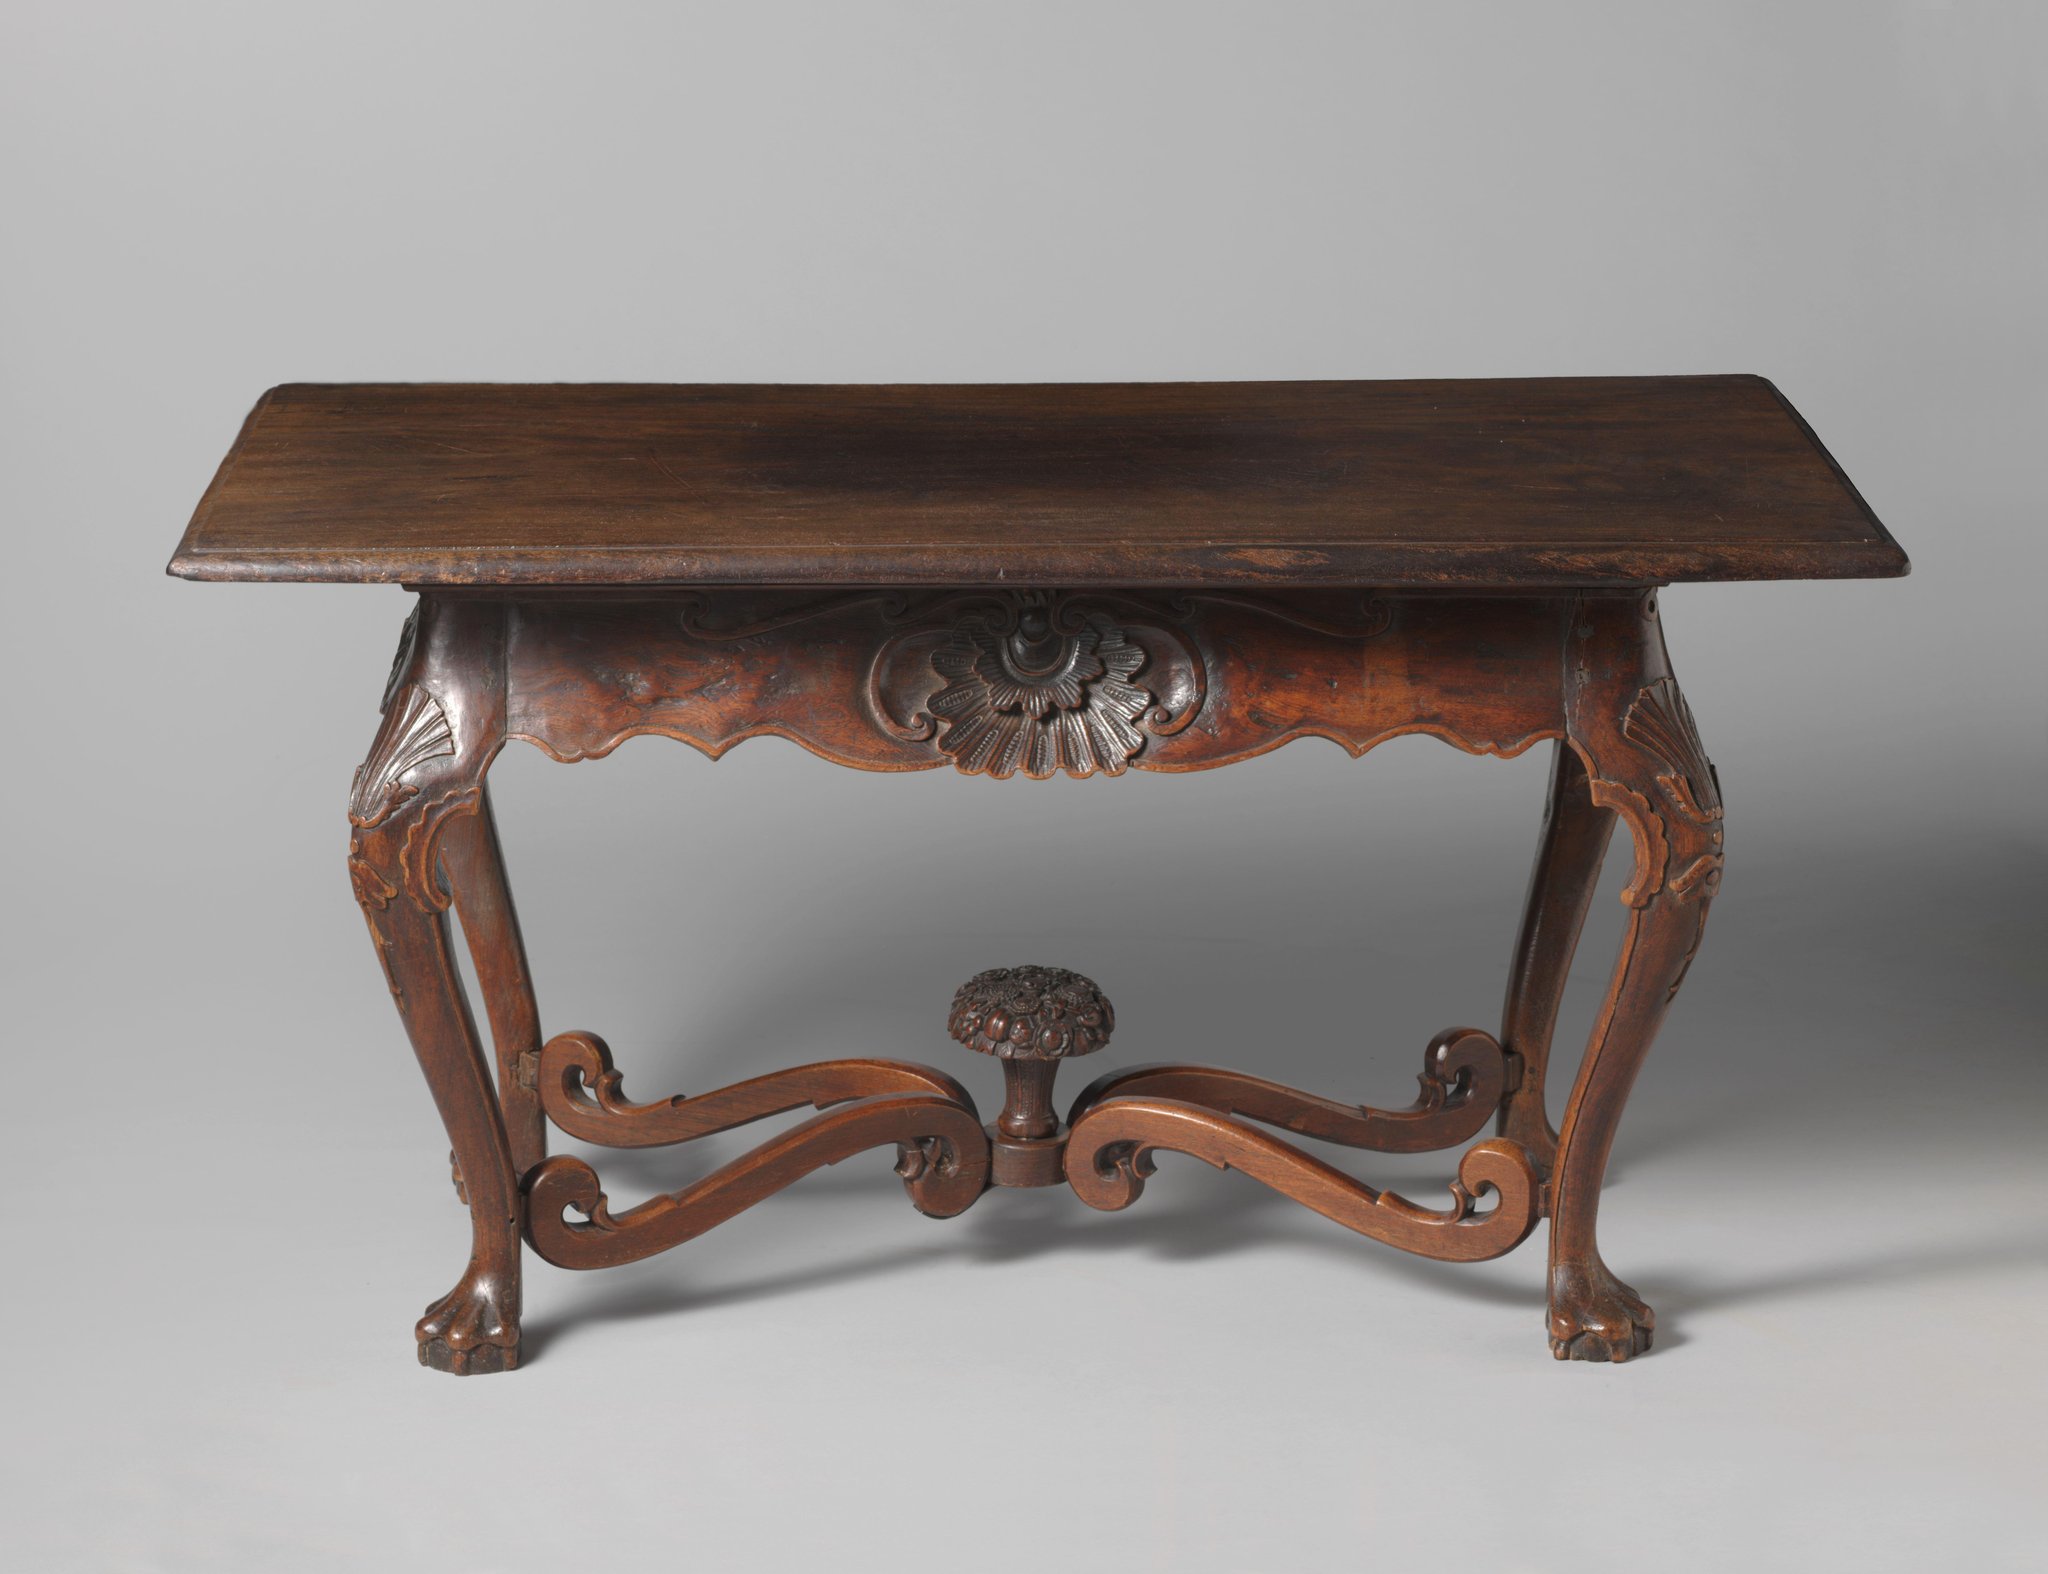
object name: table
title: Tafel van Indonesisch hout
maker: Anonymous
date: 1720-1740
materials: wood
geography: indonesia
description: Table. Teak. Indonesia, c. 1725 - 1750 (the top is of later date).